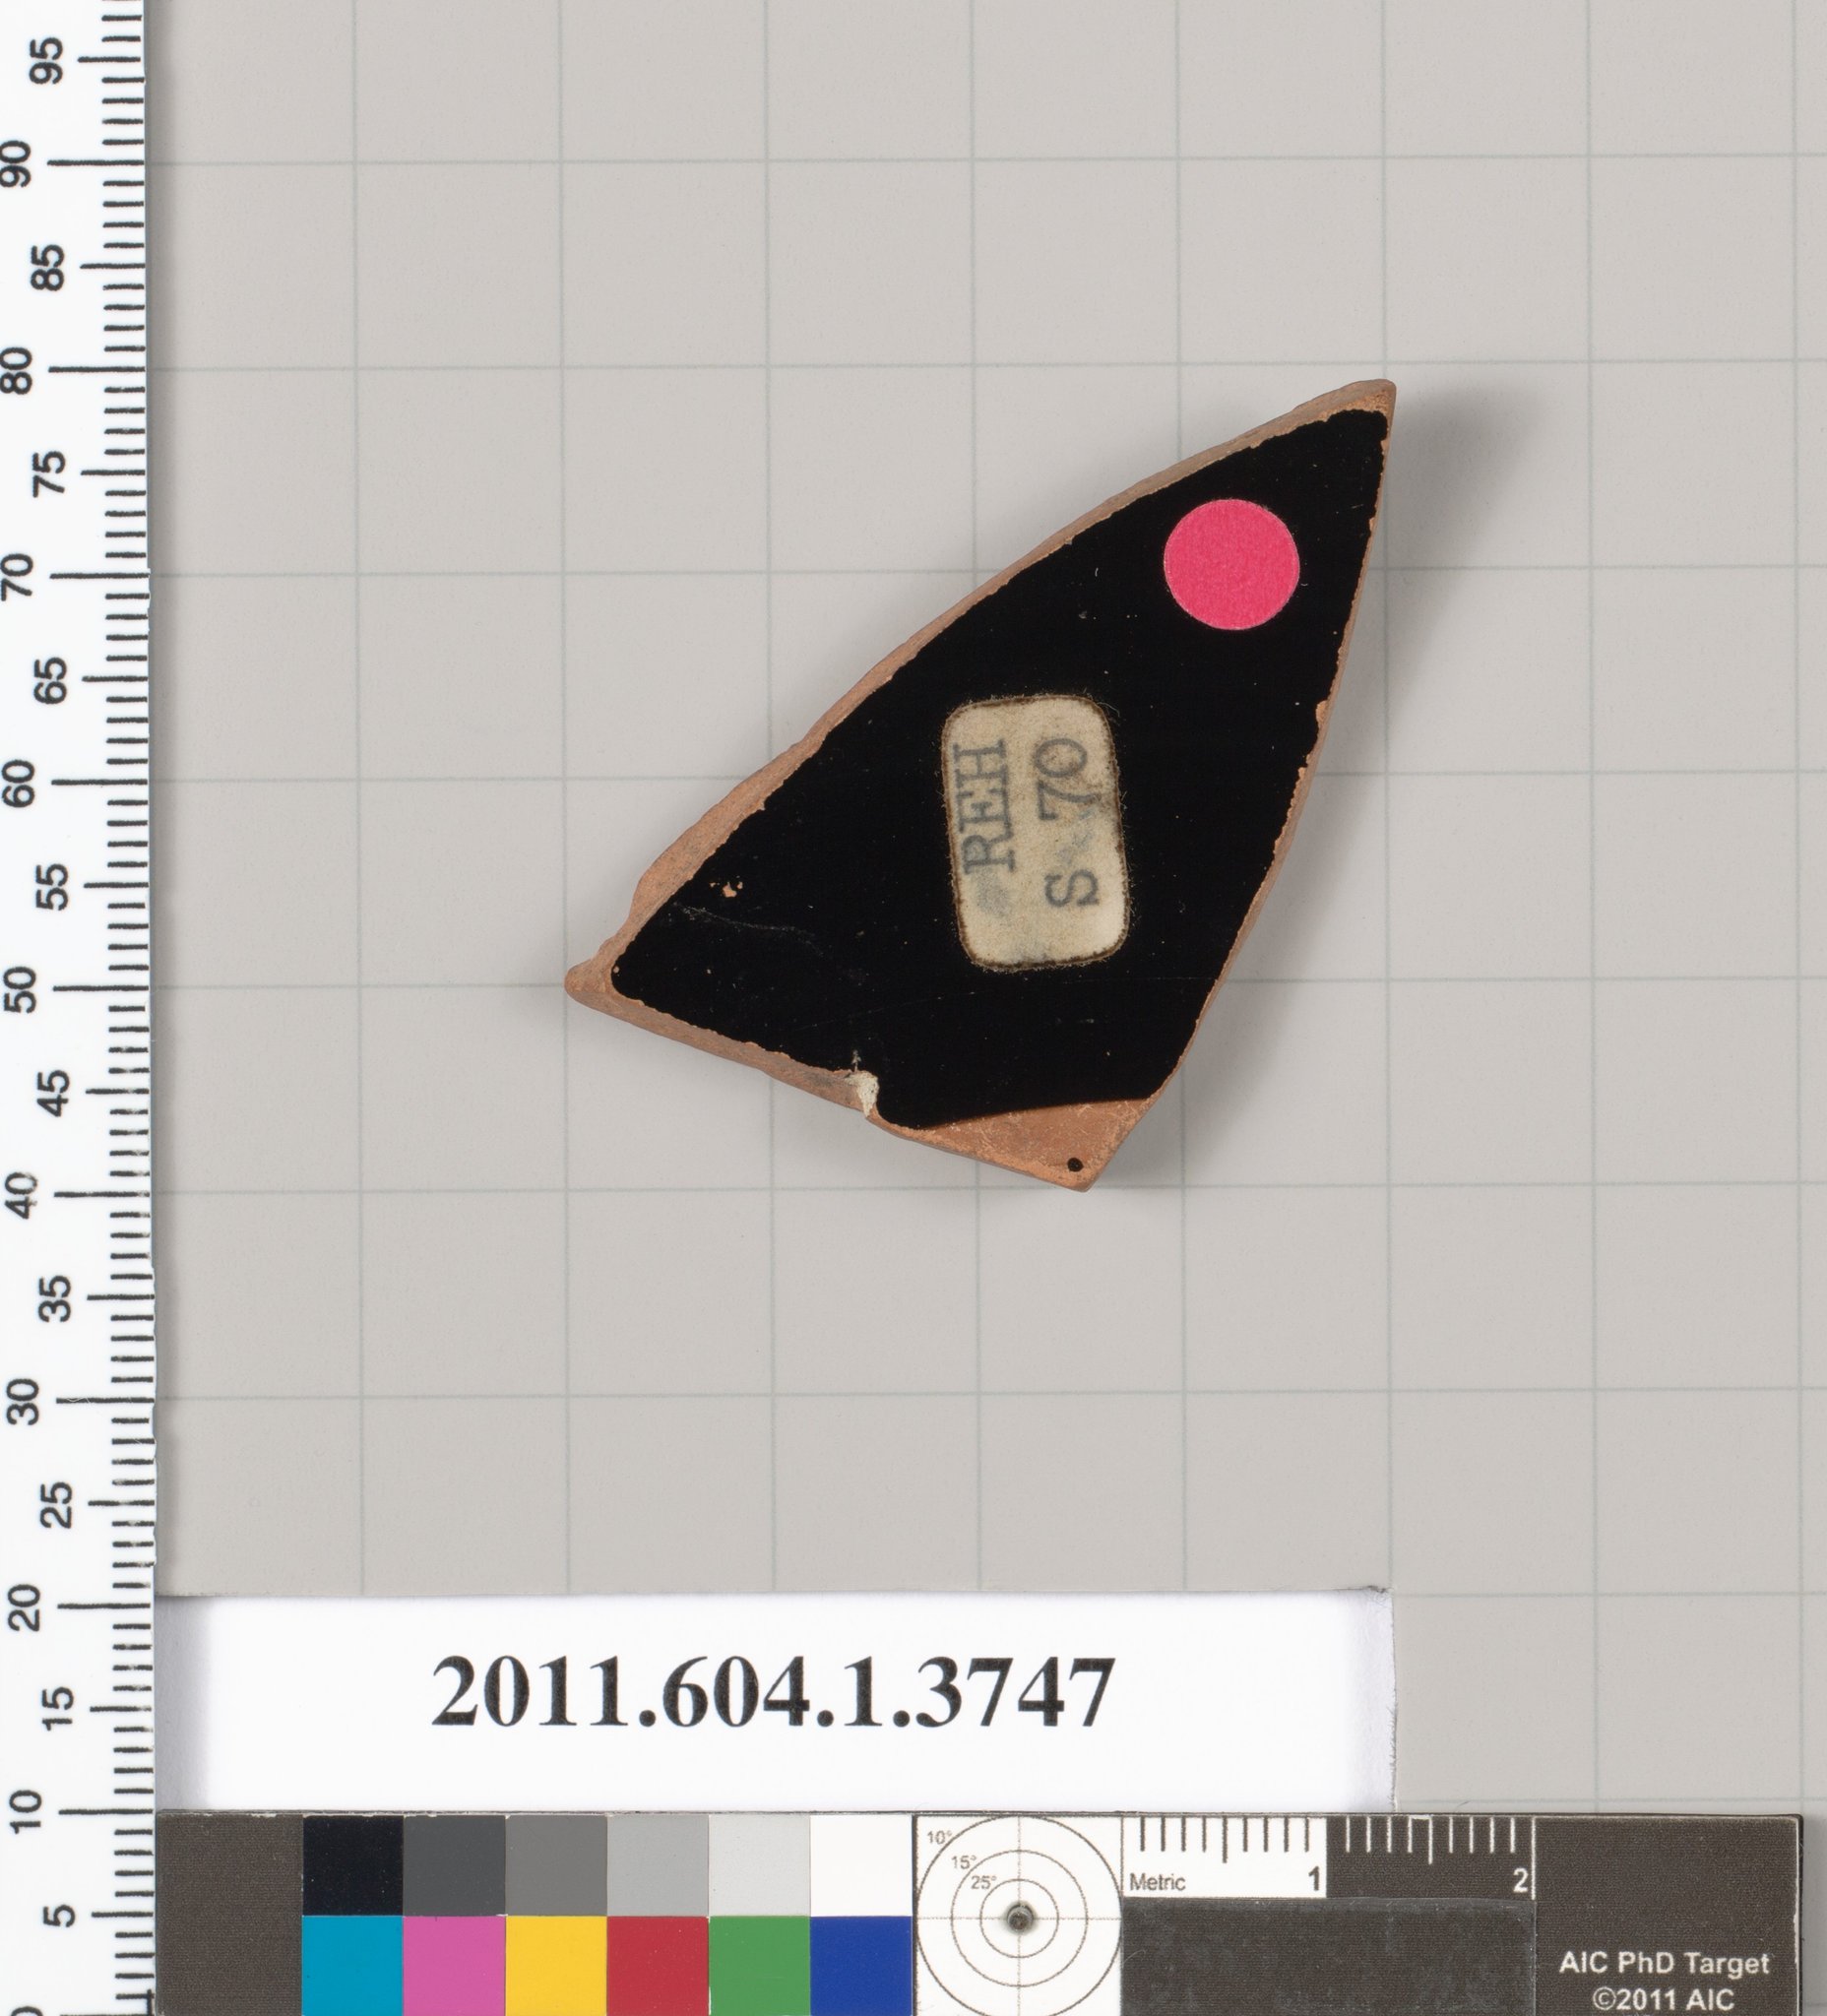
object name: kylix fragment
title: Terracotta fragment of a kylix (drinking cup)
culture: greek, attic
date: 475-451 BCE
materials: terracotta